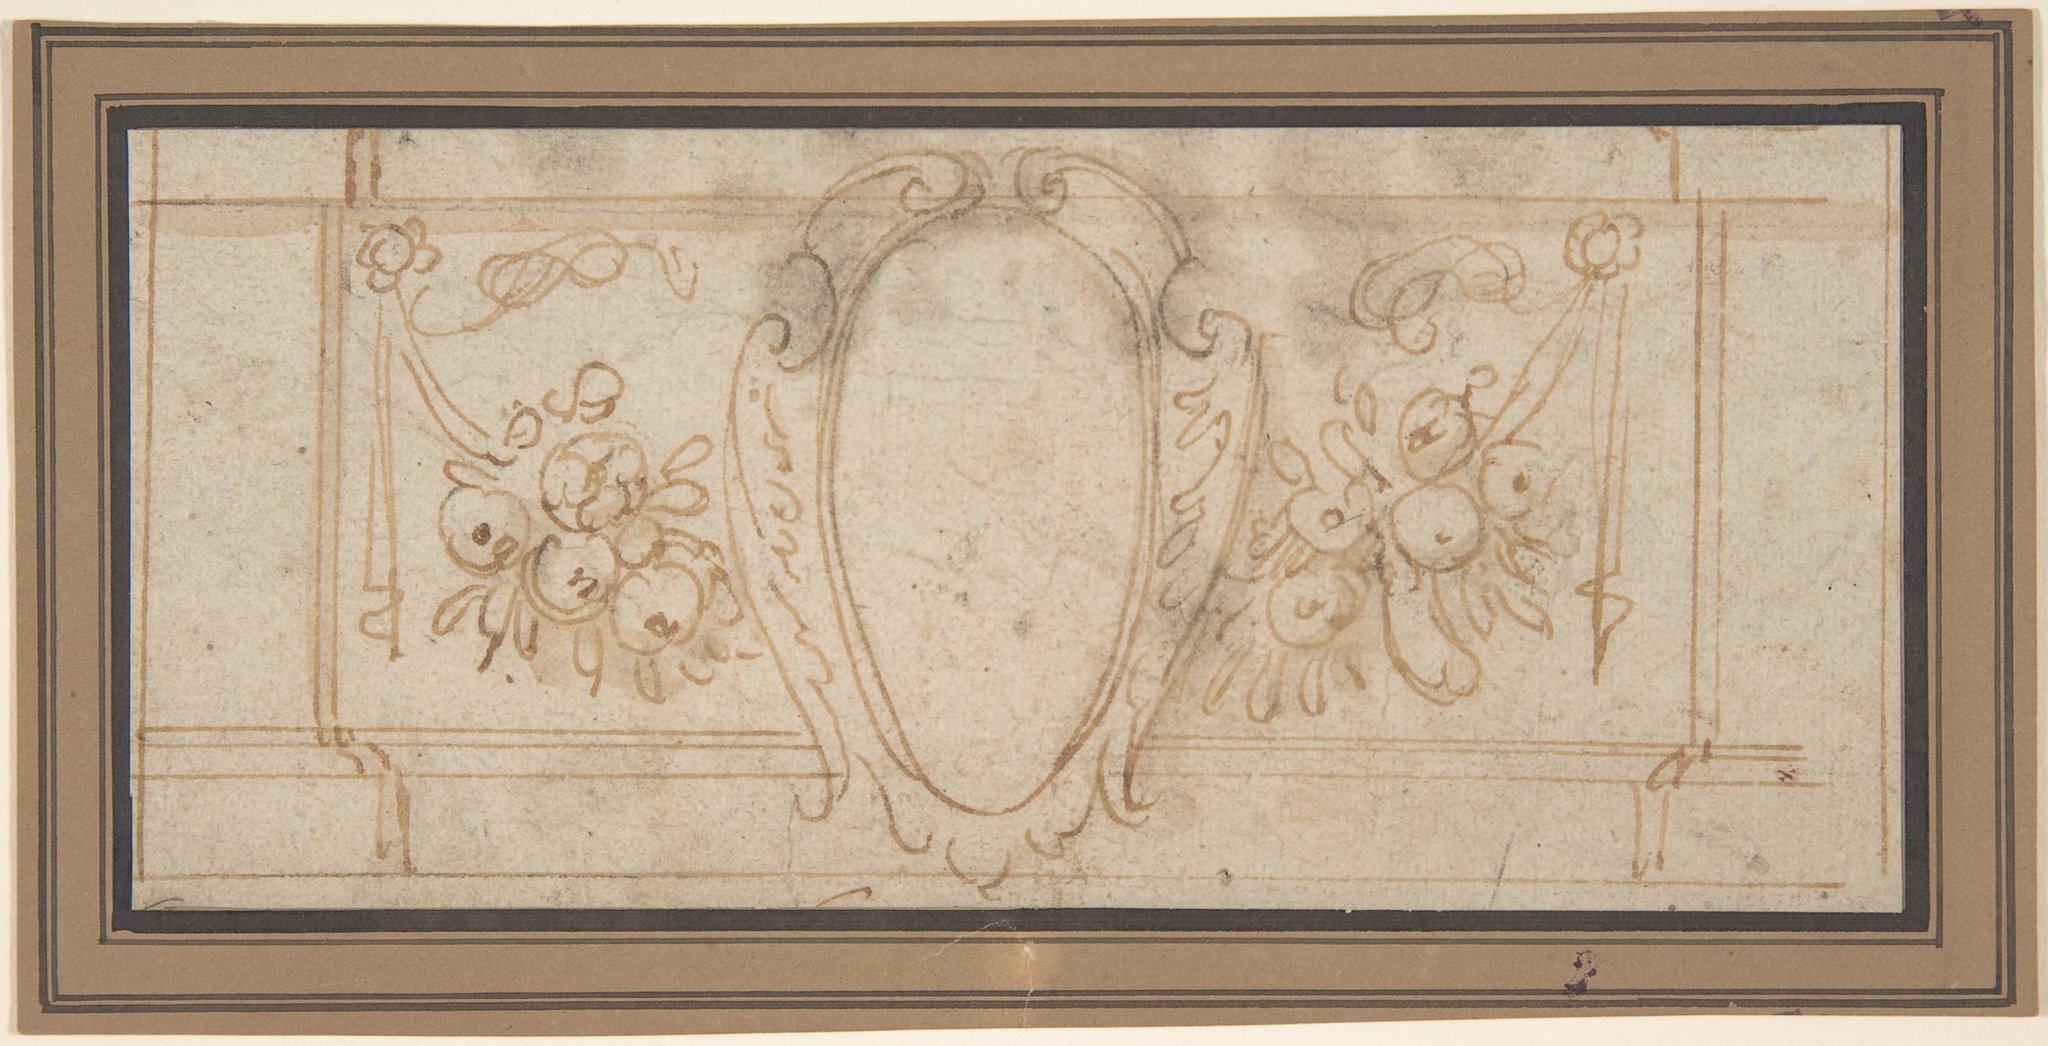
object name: drawing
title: Wall Decoration with a Cartouche and Garland (recto); Ruled Lines in Red Chalk (verso)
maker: anonymous, italian, 17th century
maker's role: artist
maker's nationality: italian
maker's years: 1600-1700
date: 1601-1700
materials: chalk, ink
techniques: brush, pen, wash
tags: cartouches,garlands